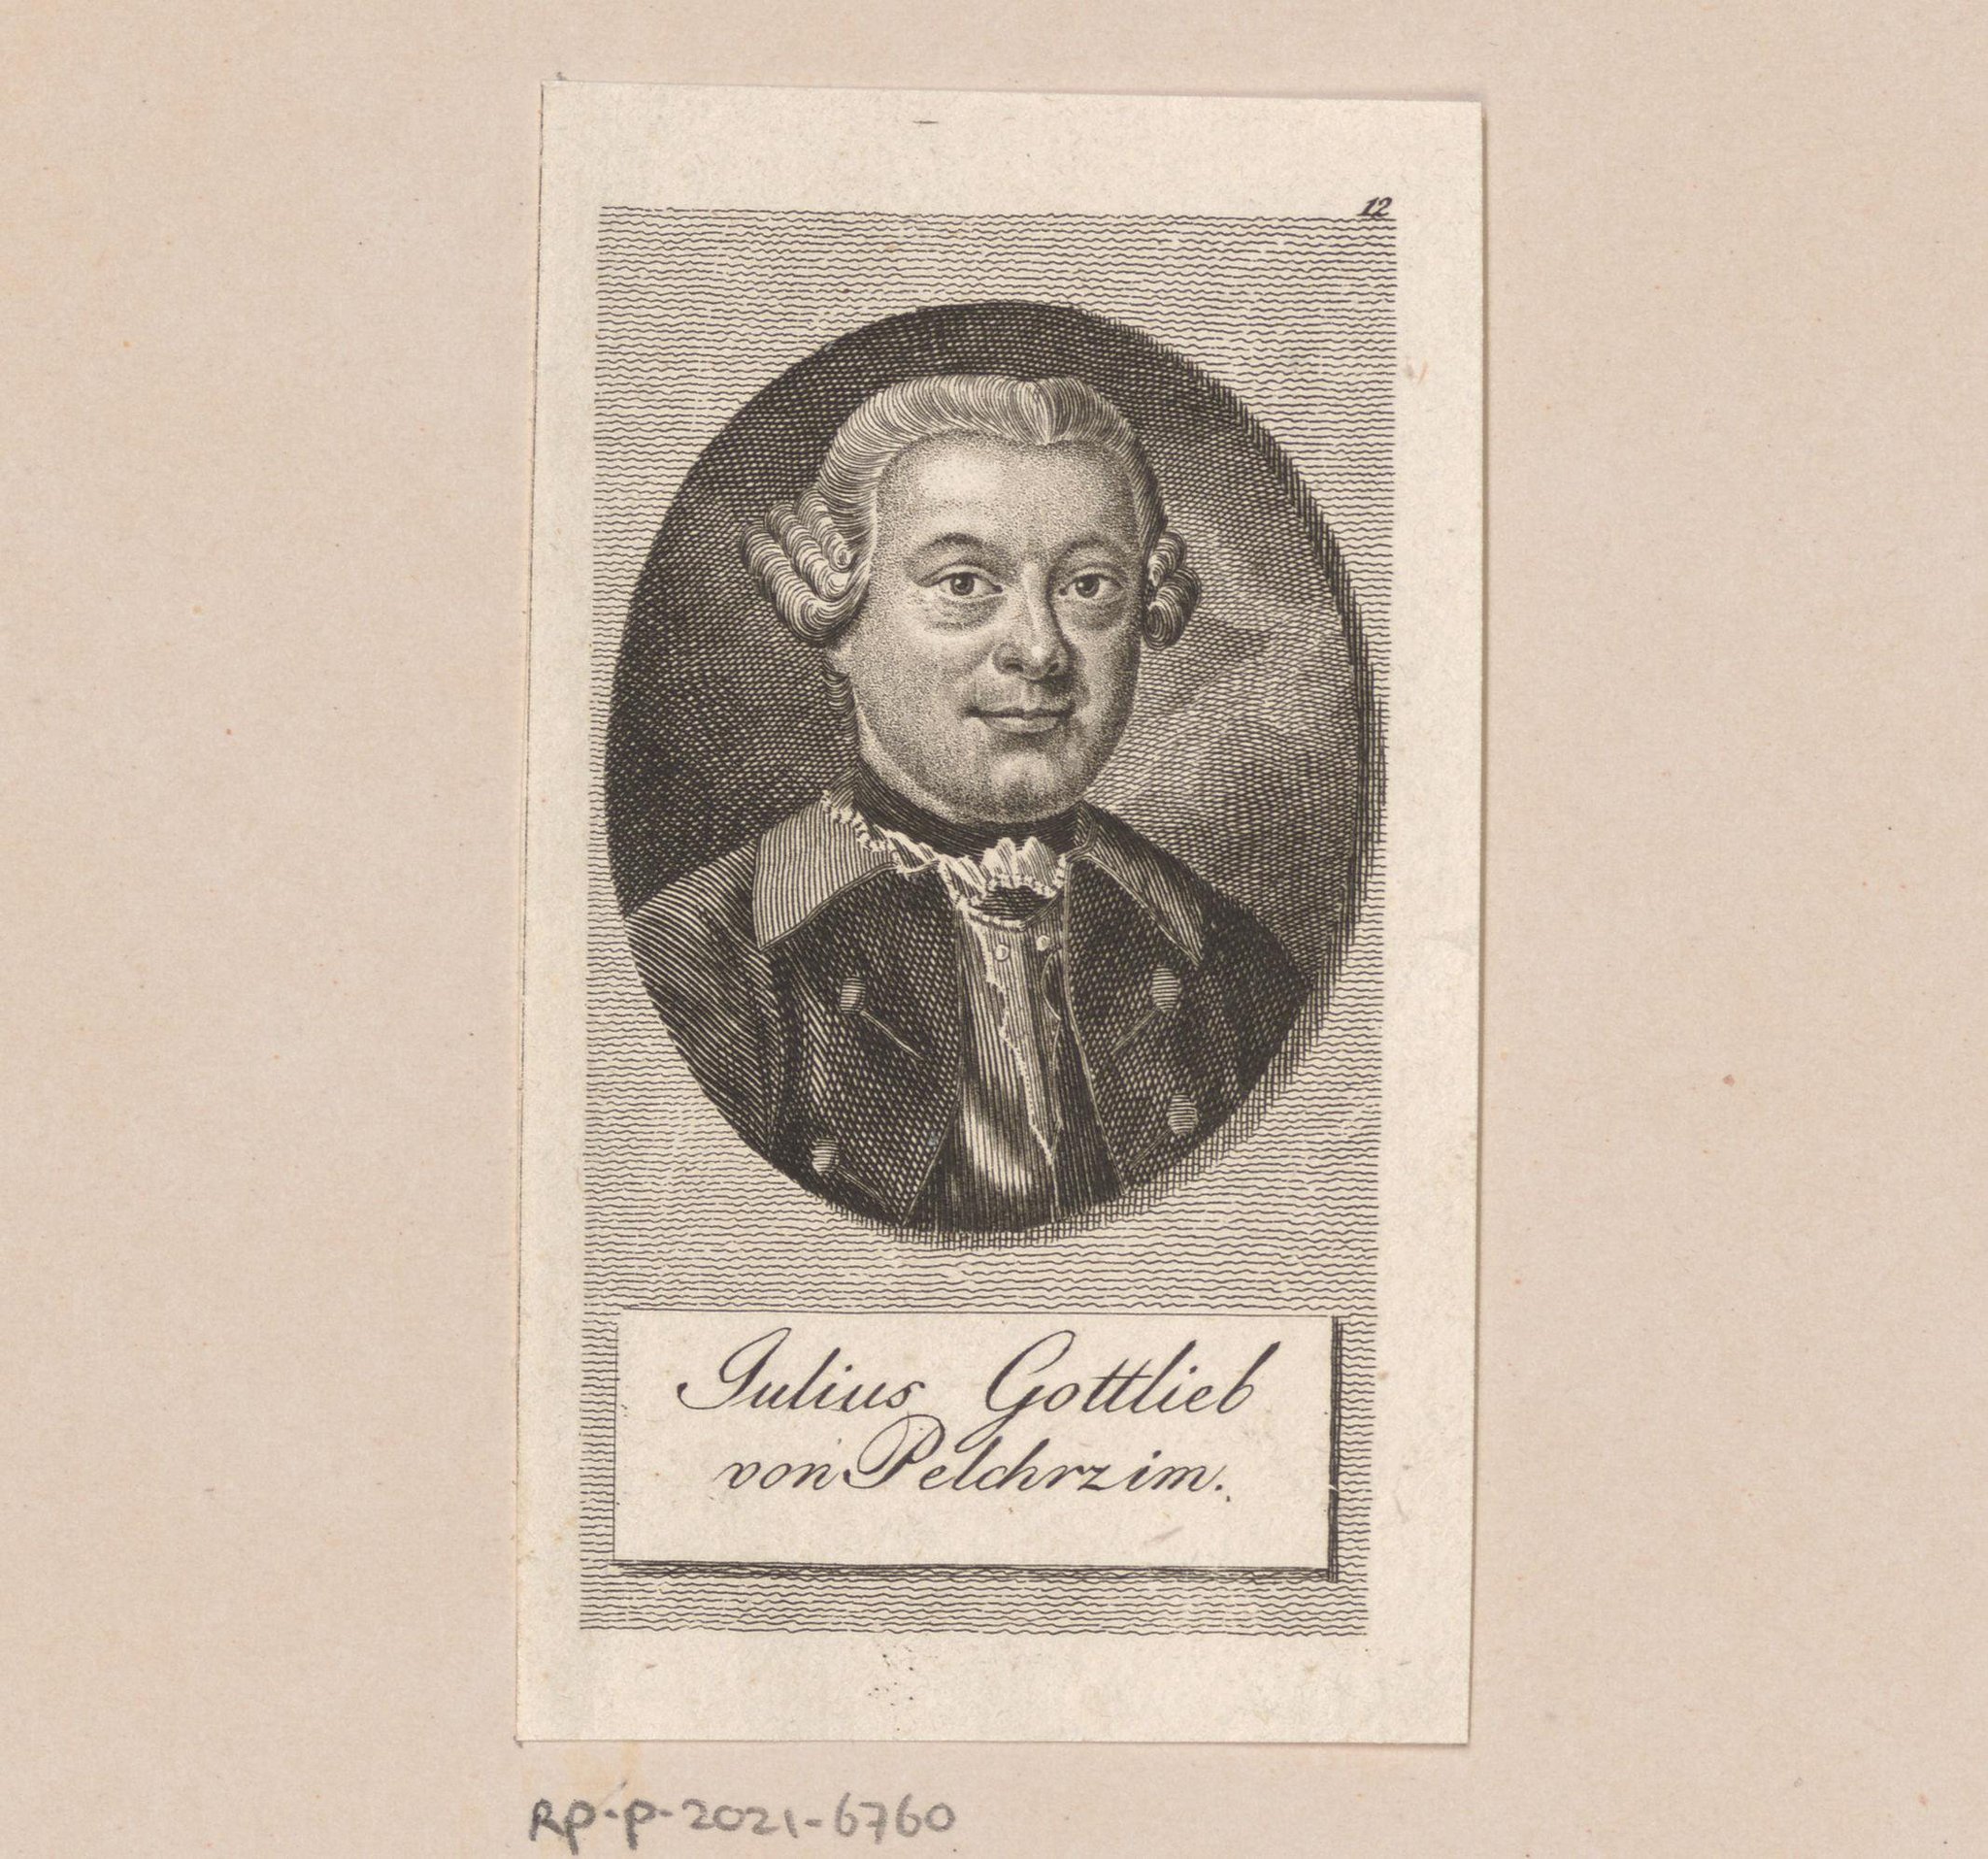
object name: print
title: Portret van Julius Gottlieb von Pelchrzim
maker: Anonymous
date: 1735-1799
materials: paper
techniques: engraving, etching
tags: adult man, historical persons